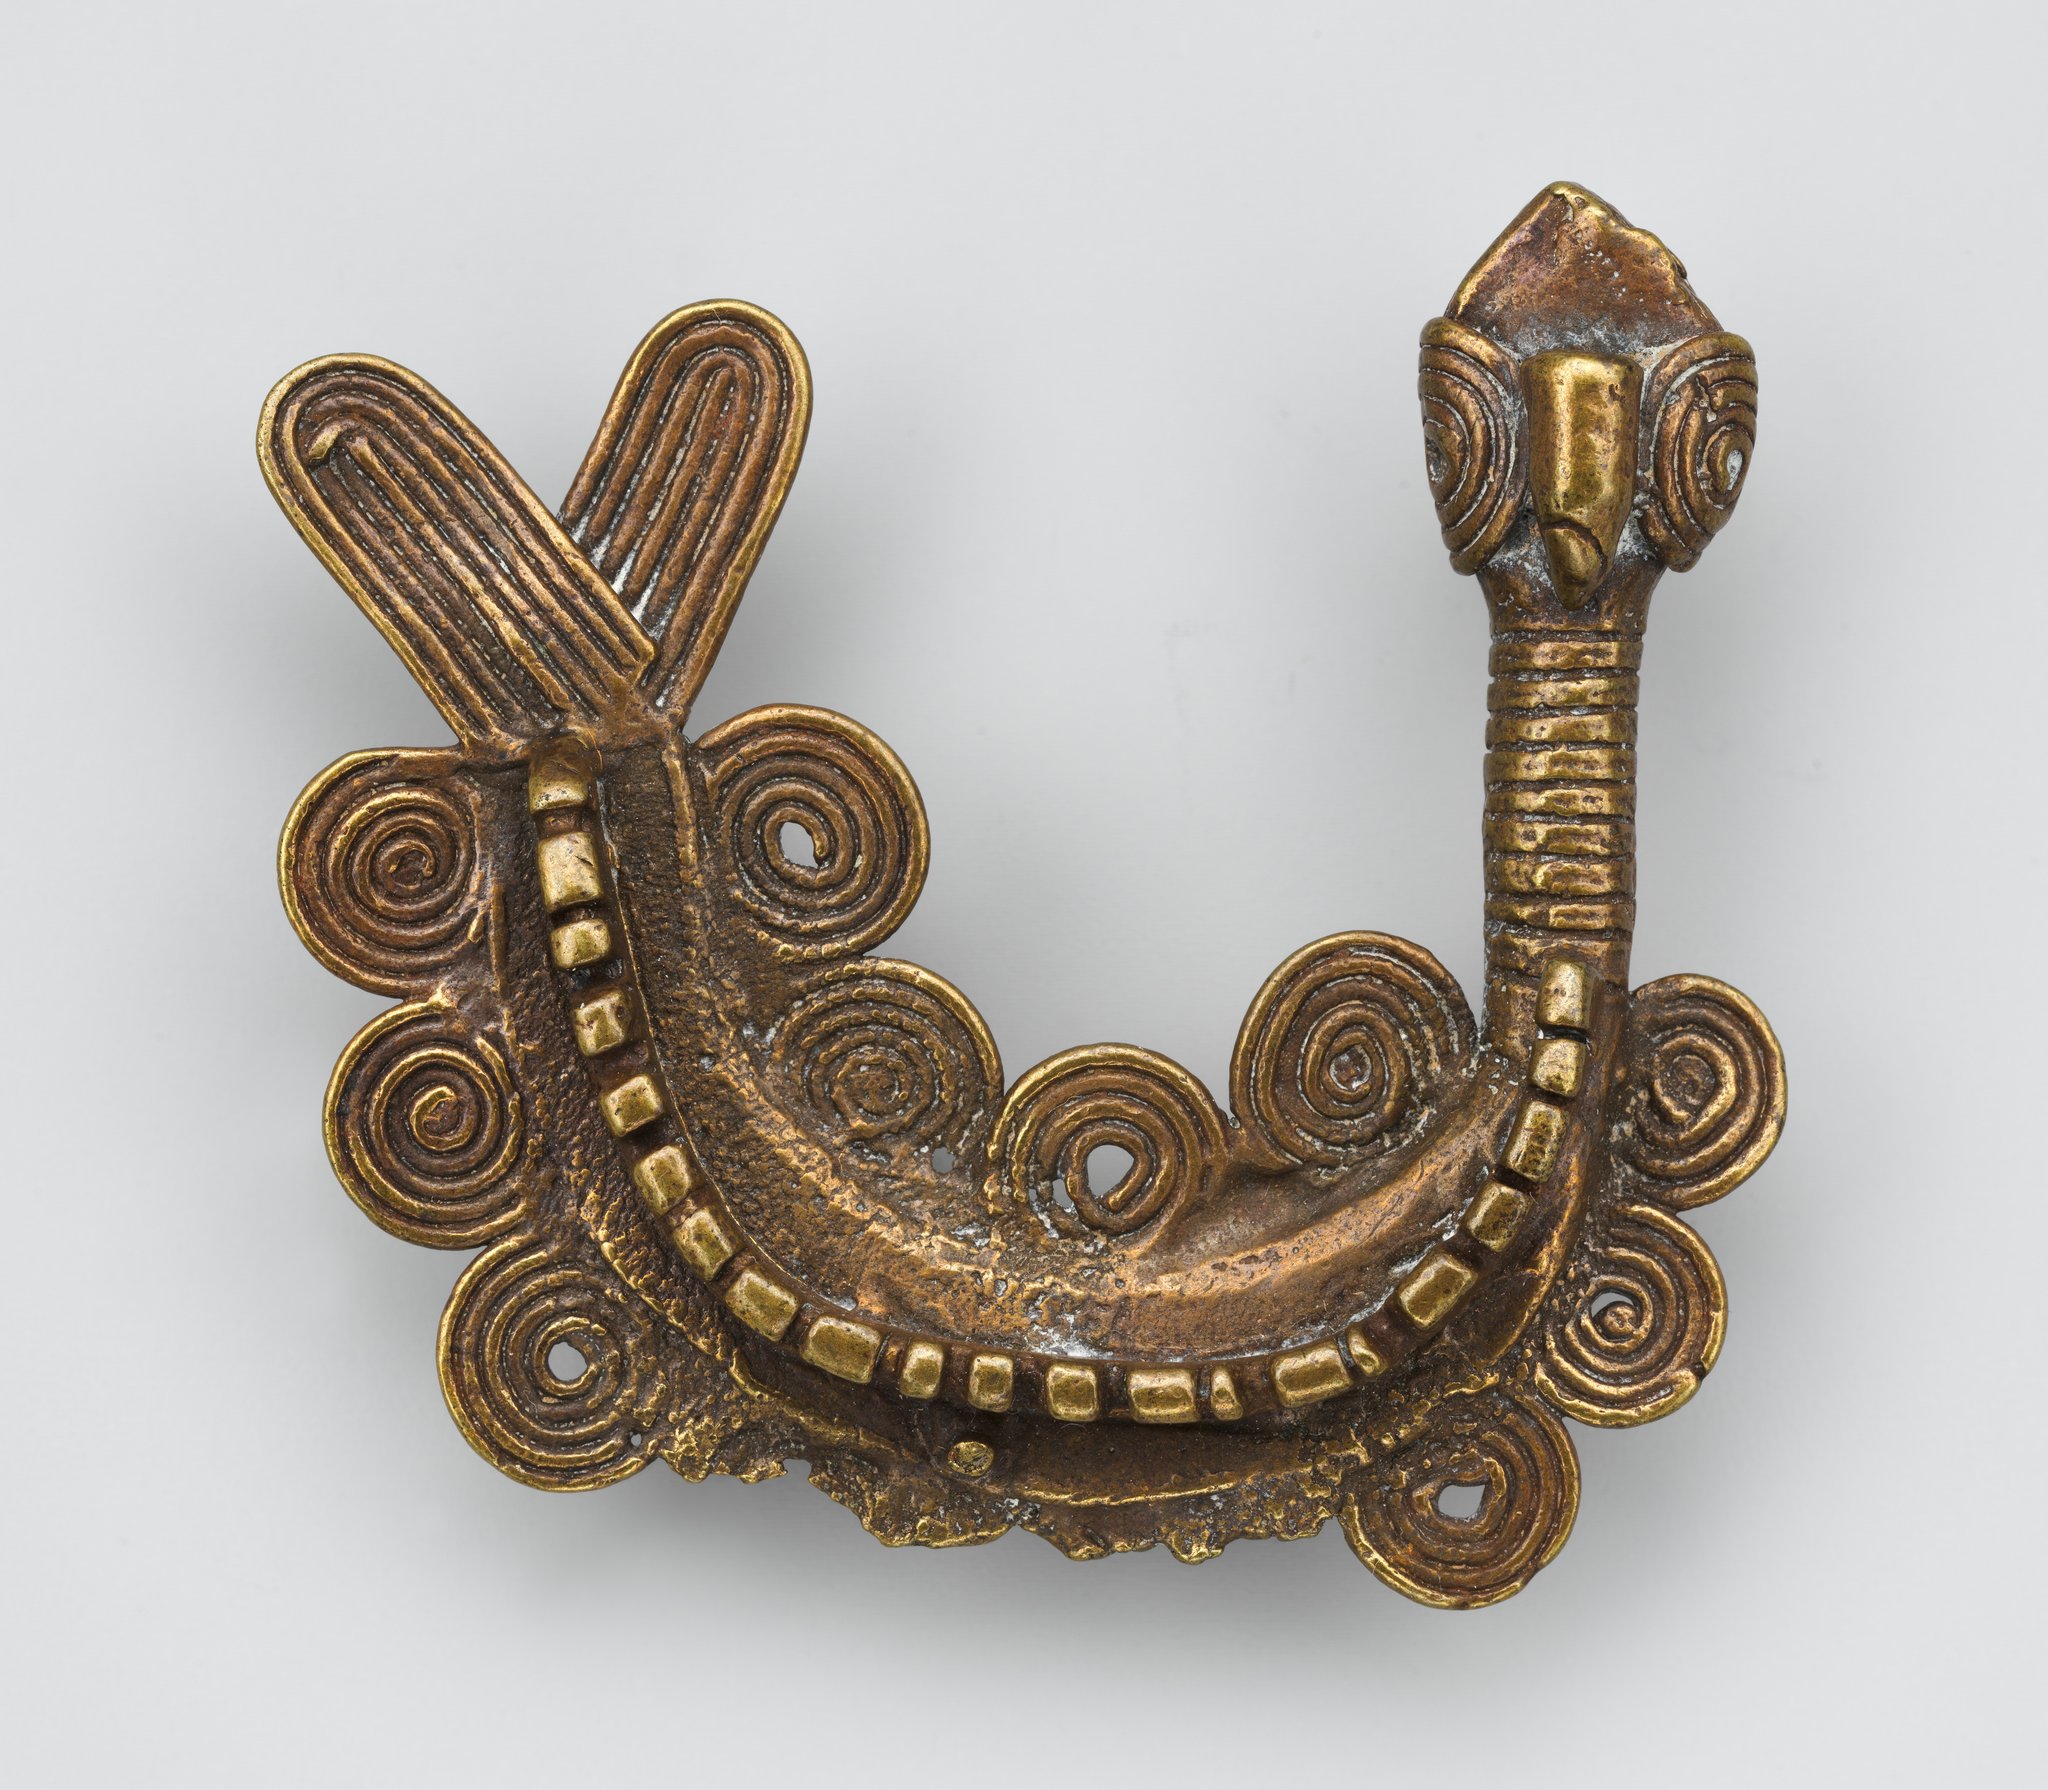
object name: weight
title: Gold Weight: Mudfish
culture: akan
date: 1701-1900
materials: brass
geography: ghana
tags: fish